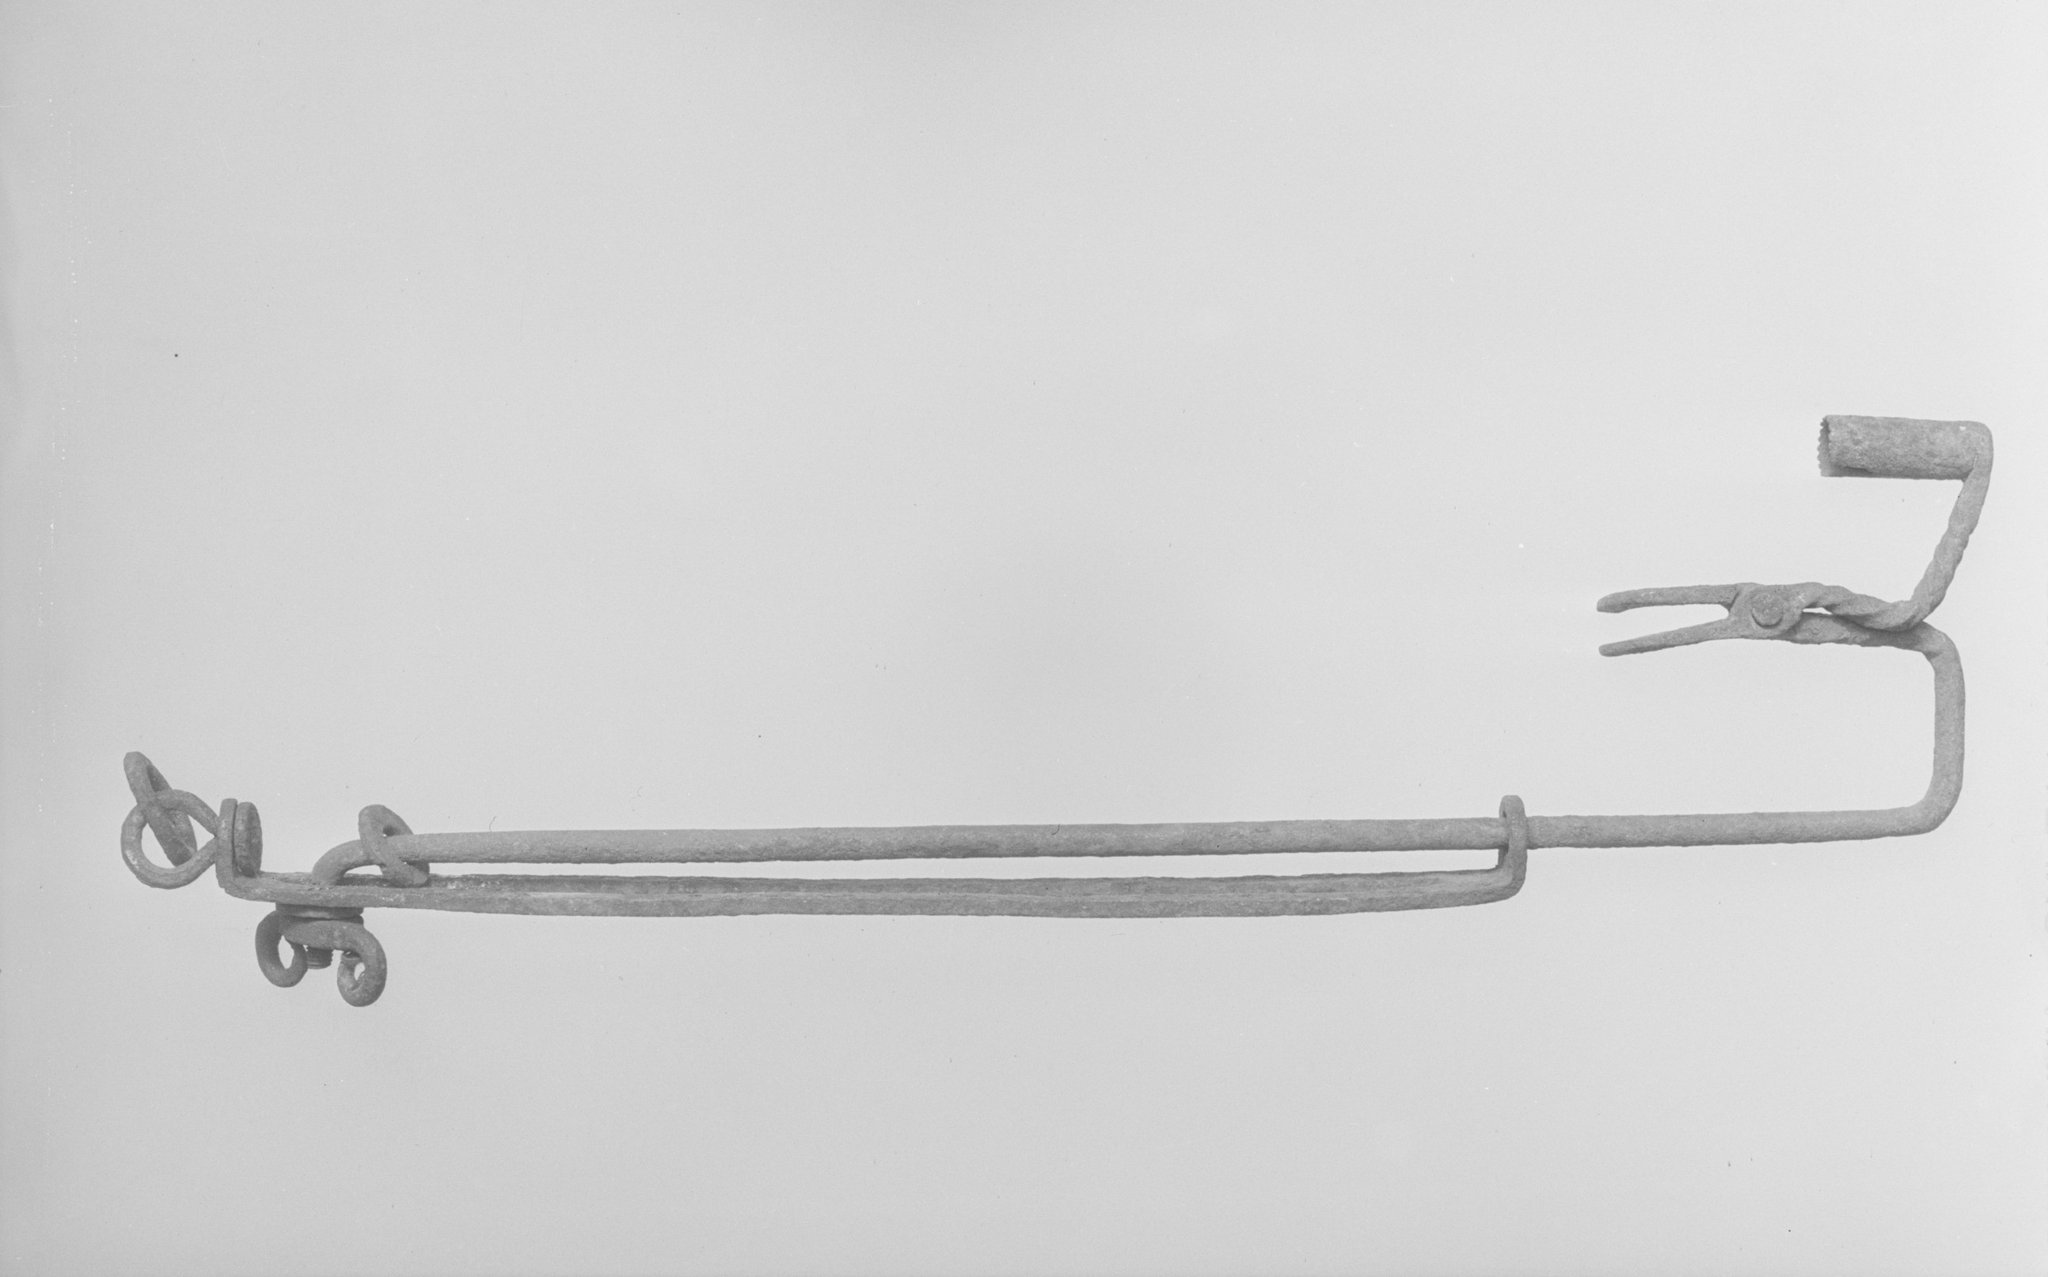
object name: candlestick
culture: american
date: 1700-1730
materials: iron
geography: united states